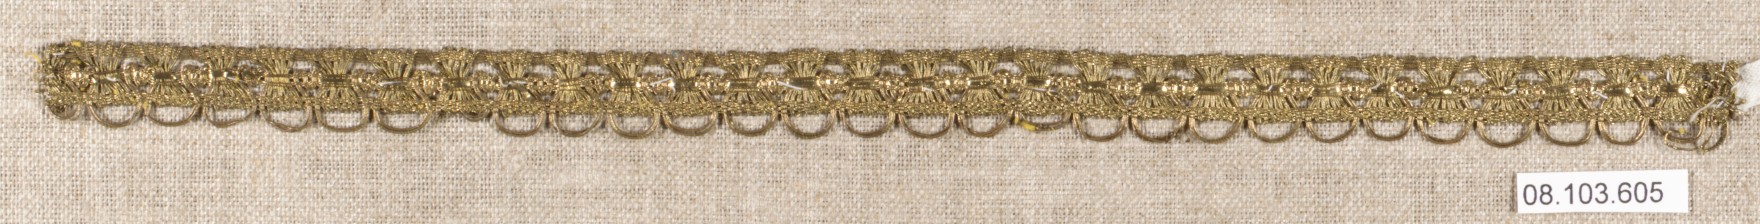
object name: galloon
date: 1701-1800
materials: metal thread